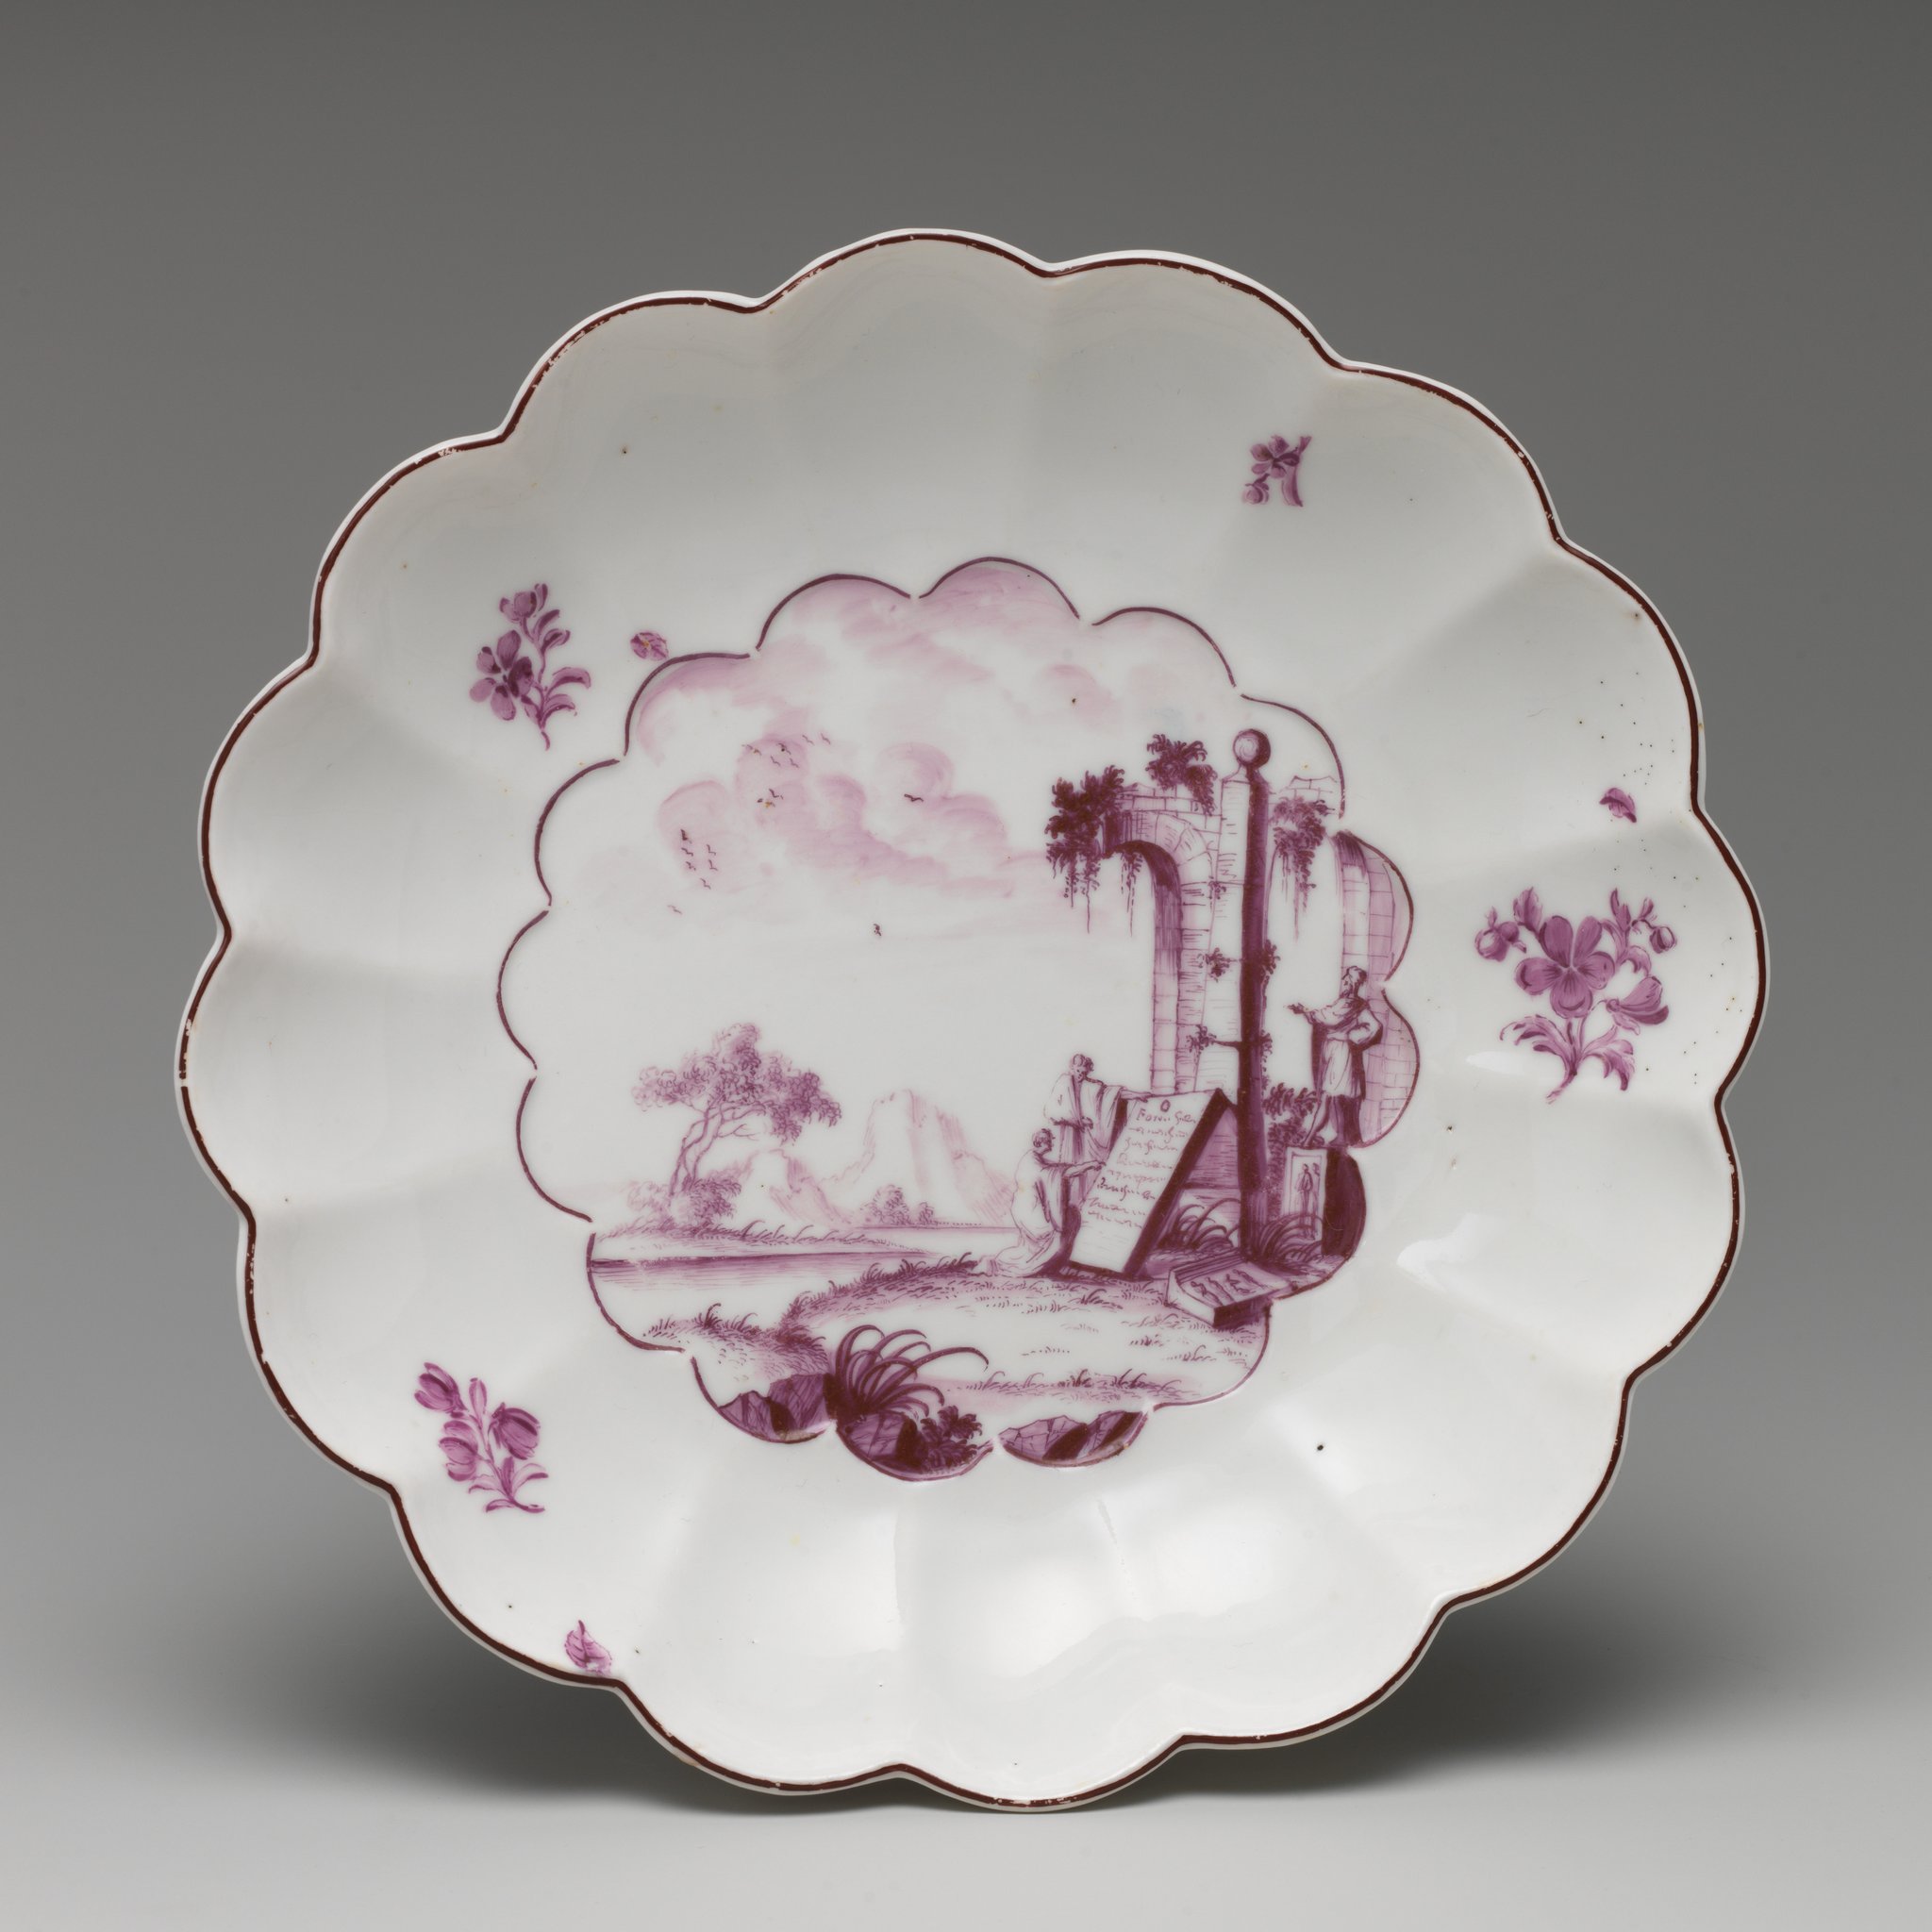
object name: dish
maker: jeffreyes hammet o'neale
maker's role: maker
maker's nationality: irish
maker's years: 1734-1801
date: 1753-1754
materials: soft paste porcelain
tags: human figures,landscapes,trees